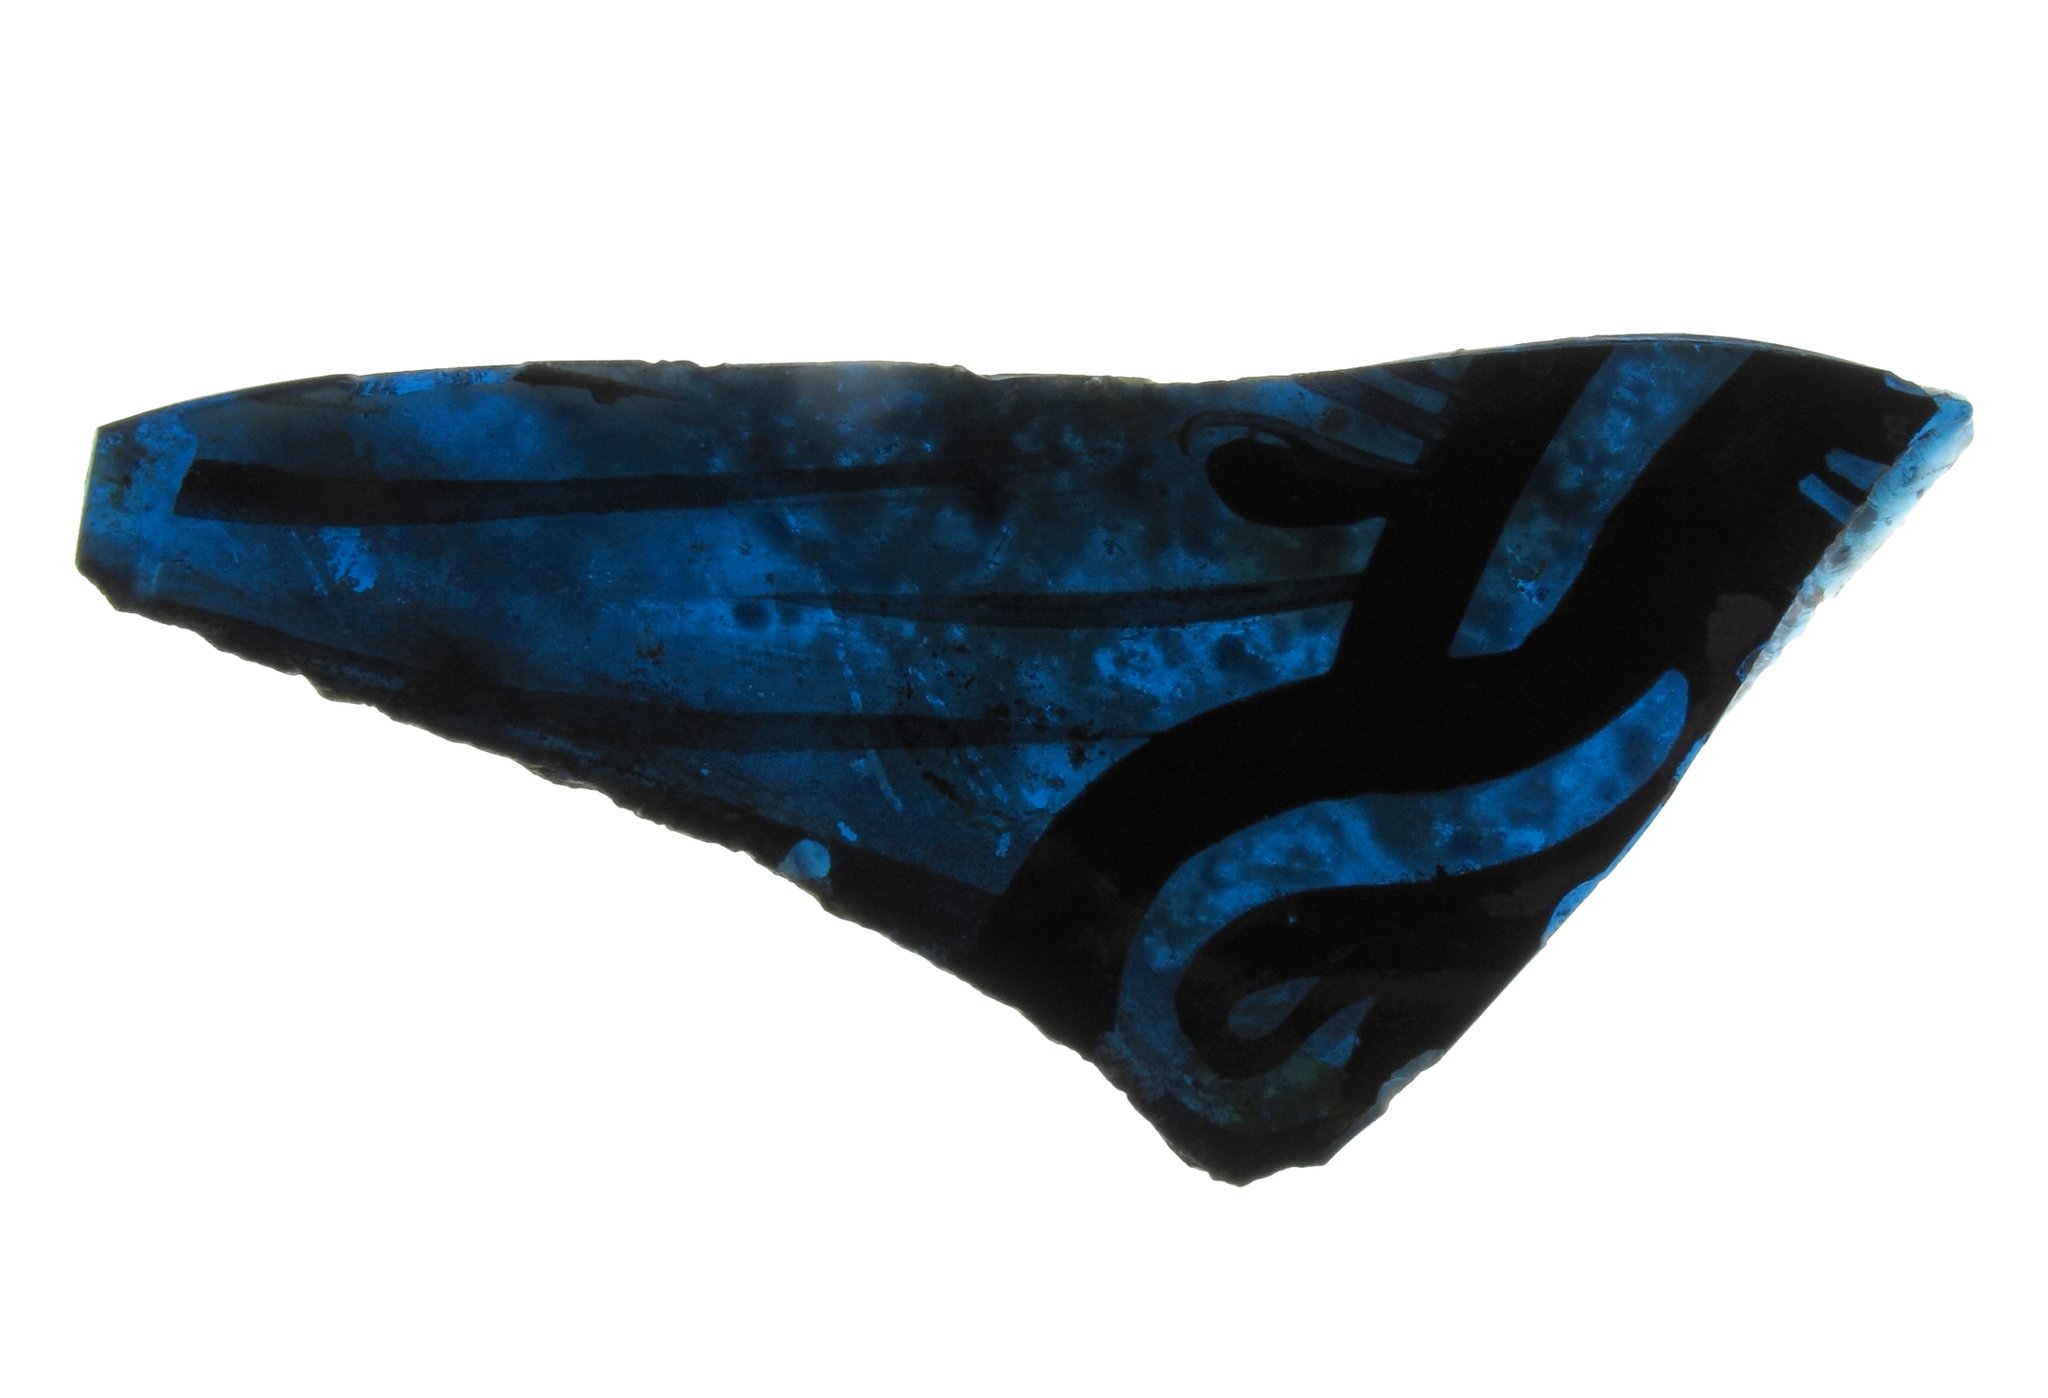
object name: fragment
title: Glass Fragment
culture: european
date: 1301-1400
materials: glass, metal